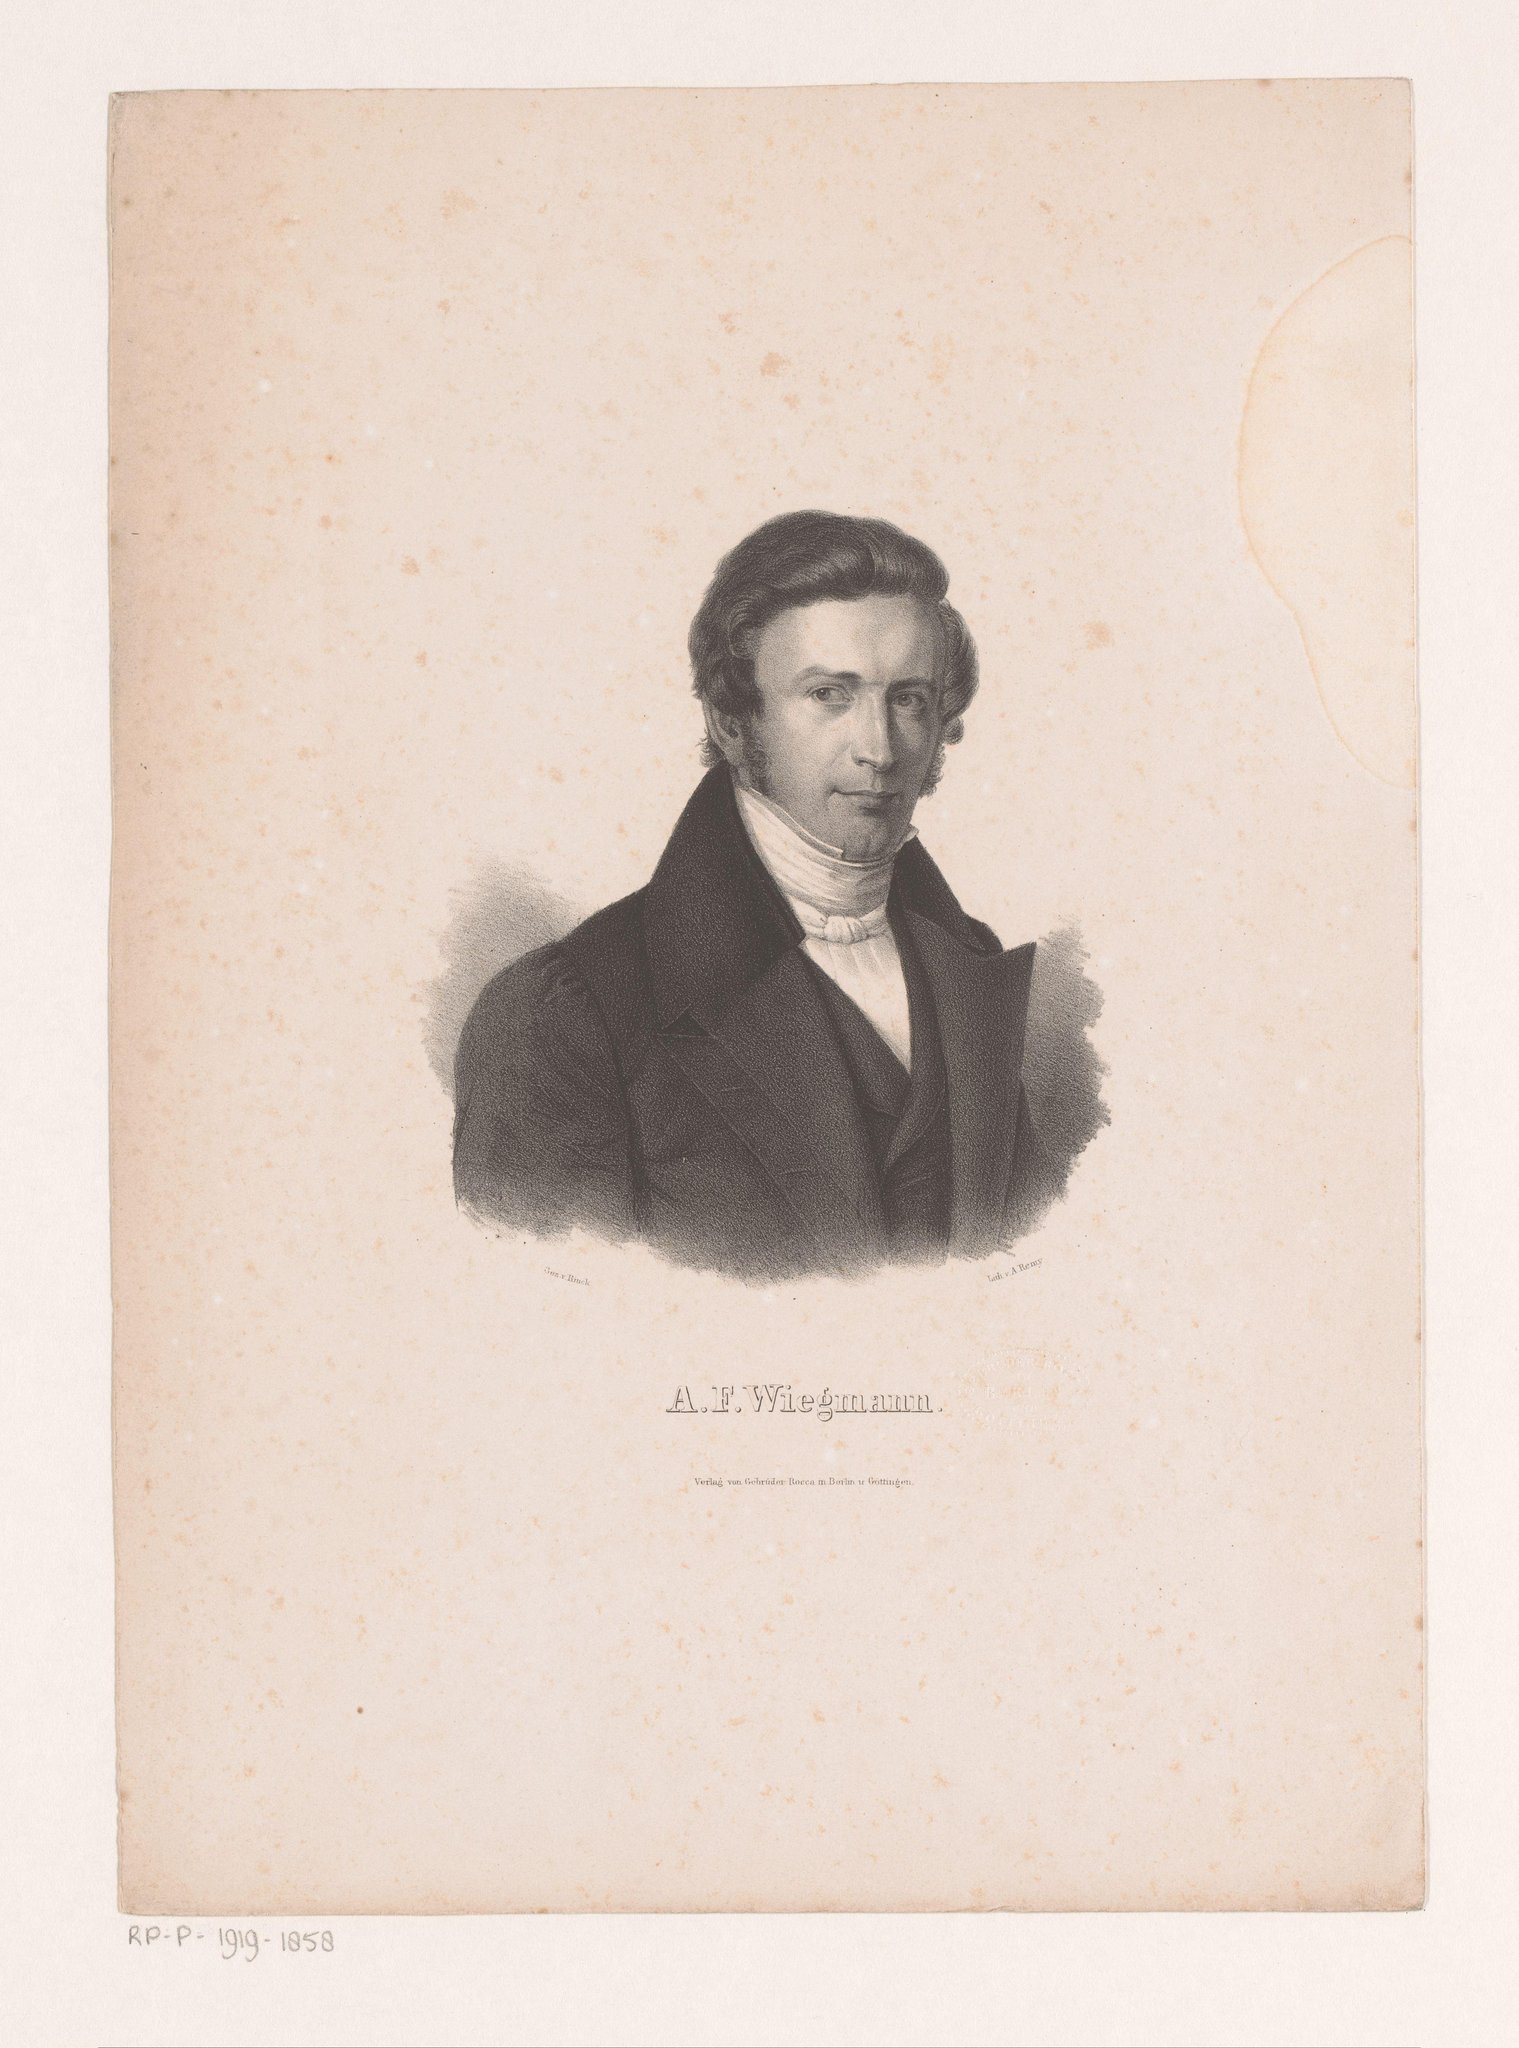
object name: print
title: Portret van Arend Friedrich August Wiegmann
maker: adolph remy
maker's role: print maker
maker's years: 1820-1865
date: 1830-1865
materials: paper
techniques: lithograph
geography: berlin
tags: historical persons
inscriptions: check stamp, collector's mark: Lugt 2228